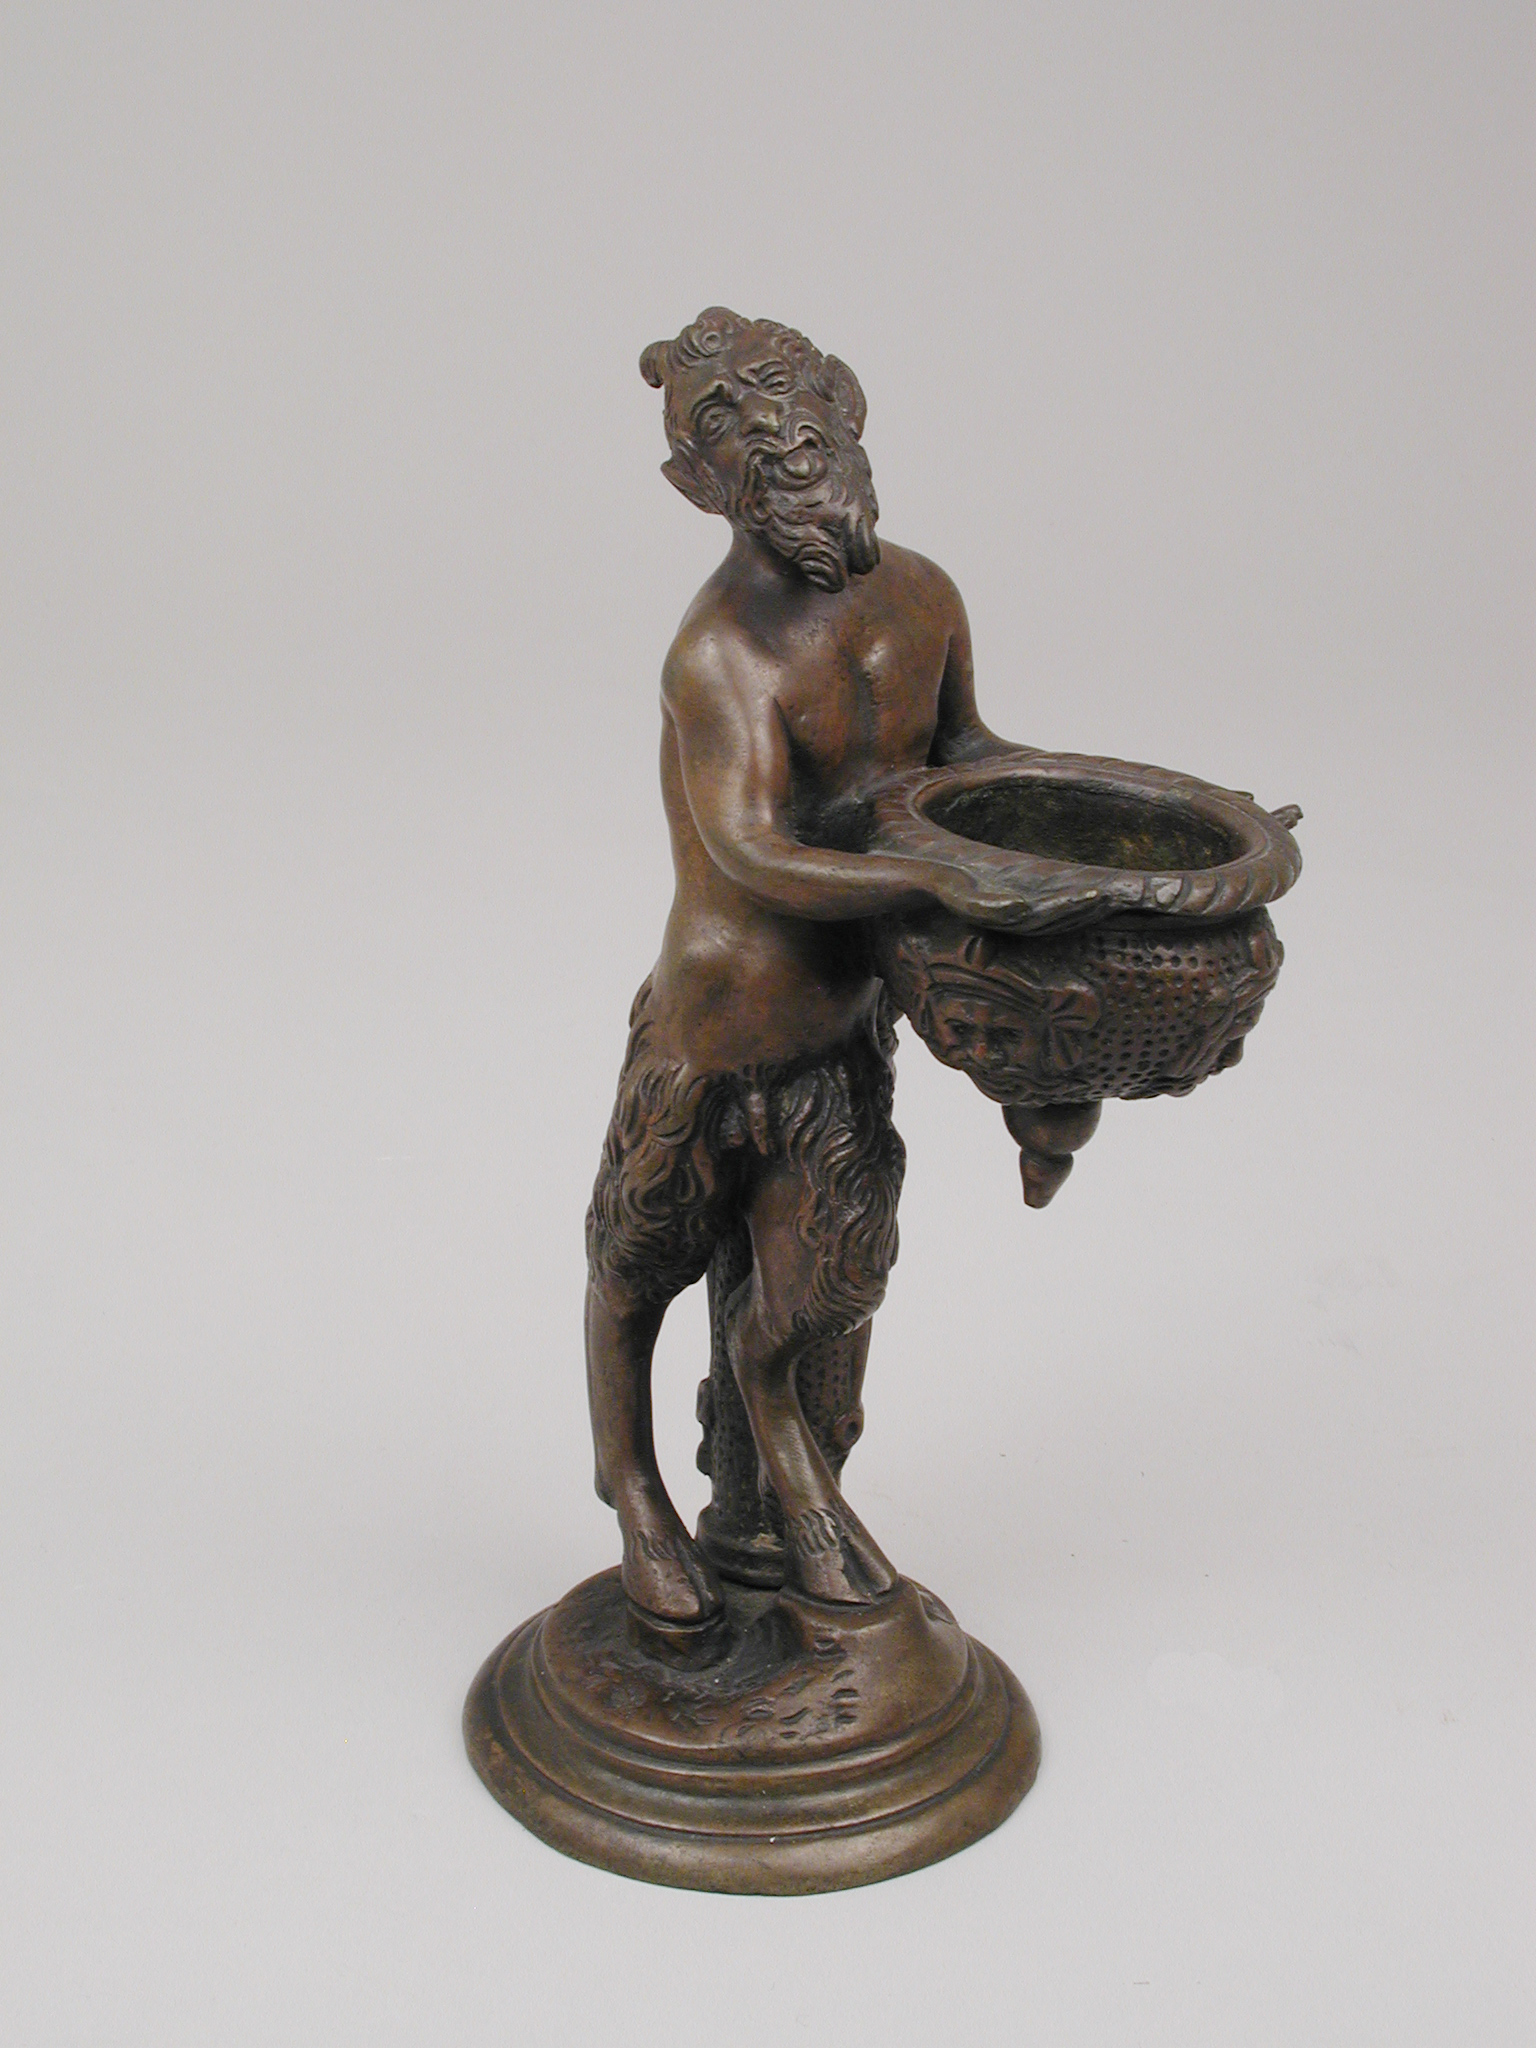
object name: statuette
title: Satyr Holding a Vessel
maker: andrea briosco, called riccio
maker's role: artist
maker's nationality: italian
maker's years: 1470-1532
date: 1601-1633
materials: brass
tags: satyrs